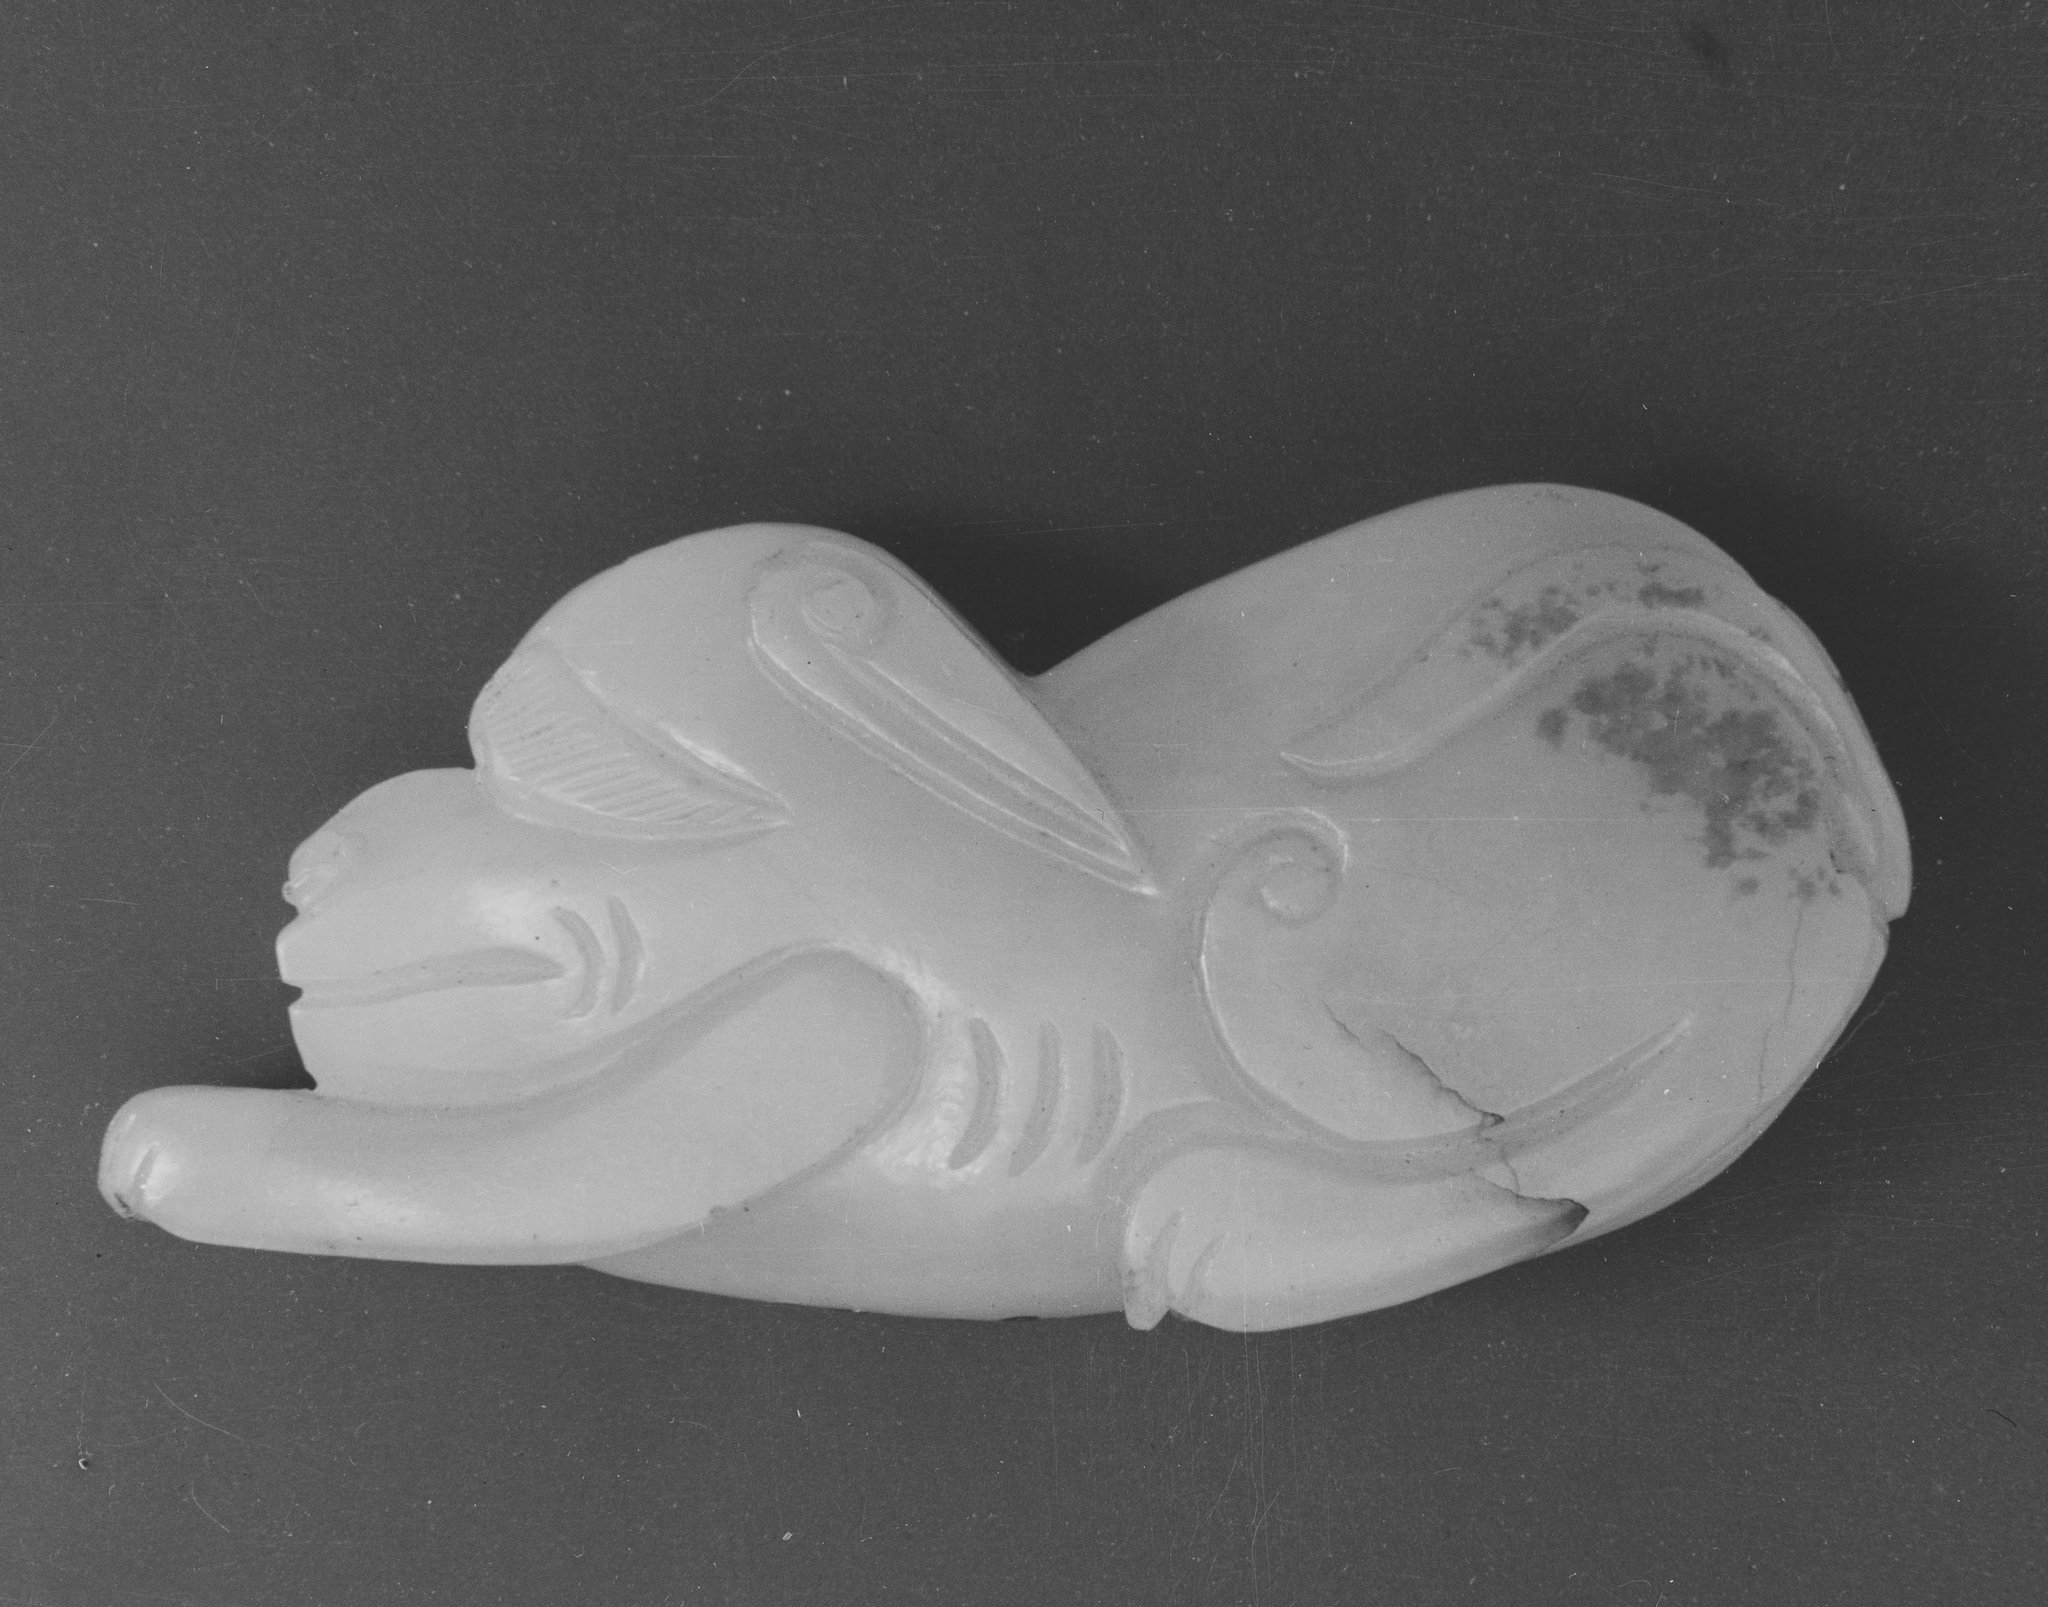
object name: dog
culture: chinese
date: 1601-1700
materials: jade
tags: dogs